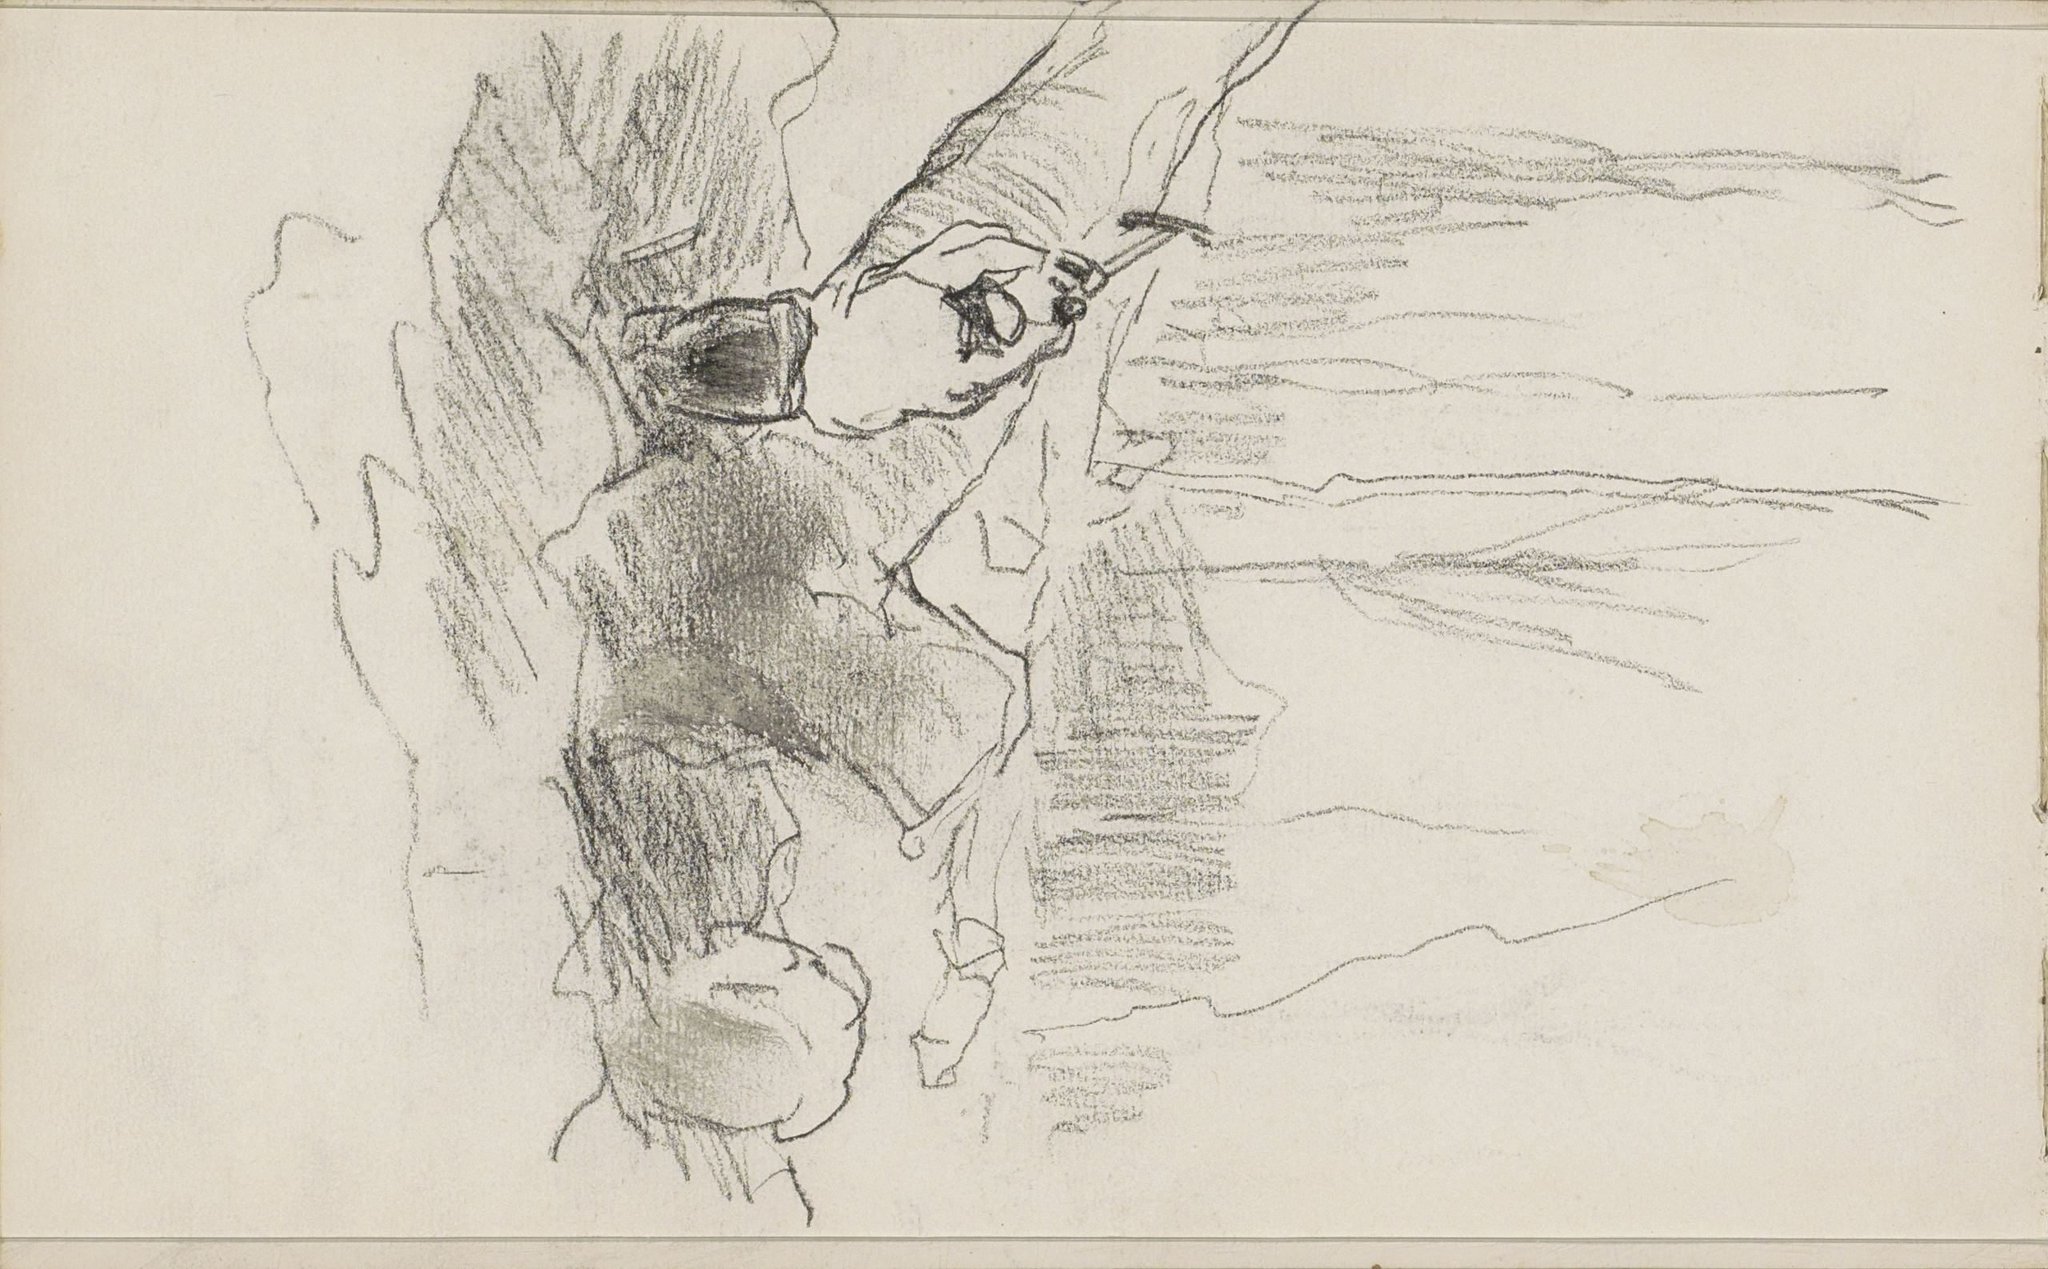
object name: sketchbook leaf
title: Houthakker met een bijl bij een omgehakte boomstam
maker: anton mauve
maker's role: draughtsman, painter, print maker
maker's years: 1838-1888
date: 1848-1888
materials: chalk, paper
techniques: brush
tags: woodcutting, woodcutter ~ forestry, tools, aids, implements ~ crafts and industries: axe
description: Blad 10 verso uit een schetsboek met 41 bladen.